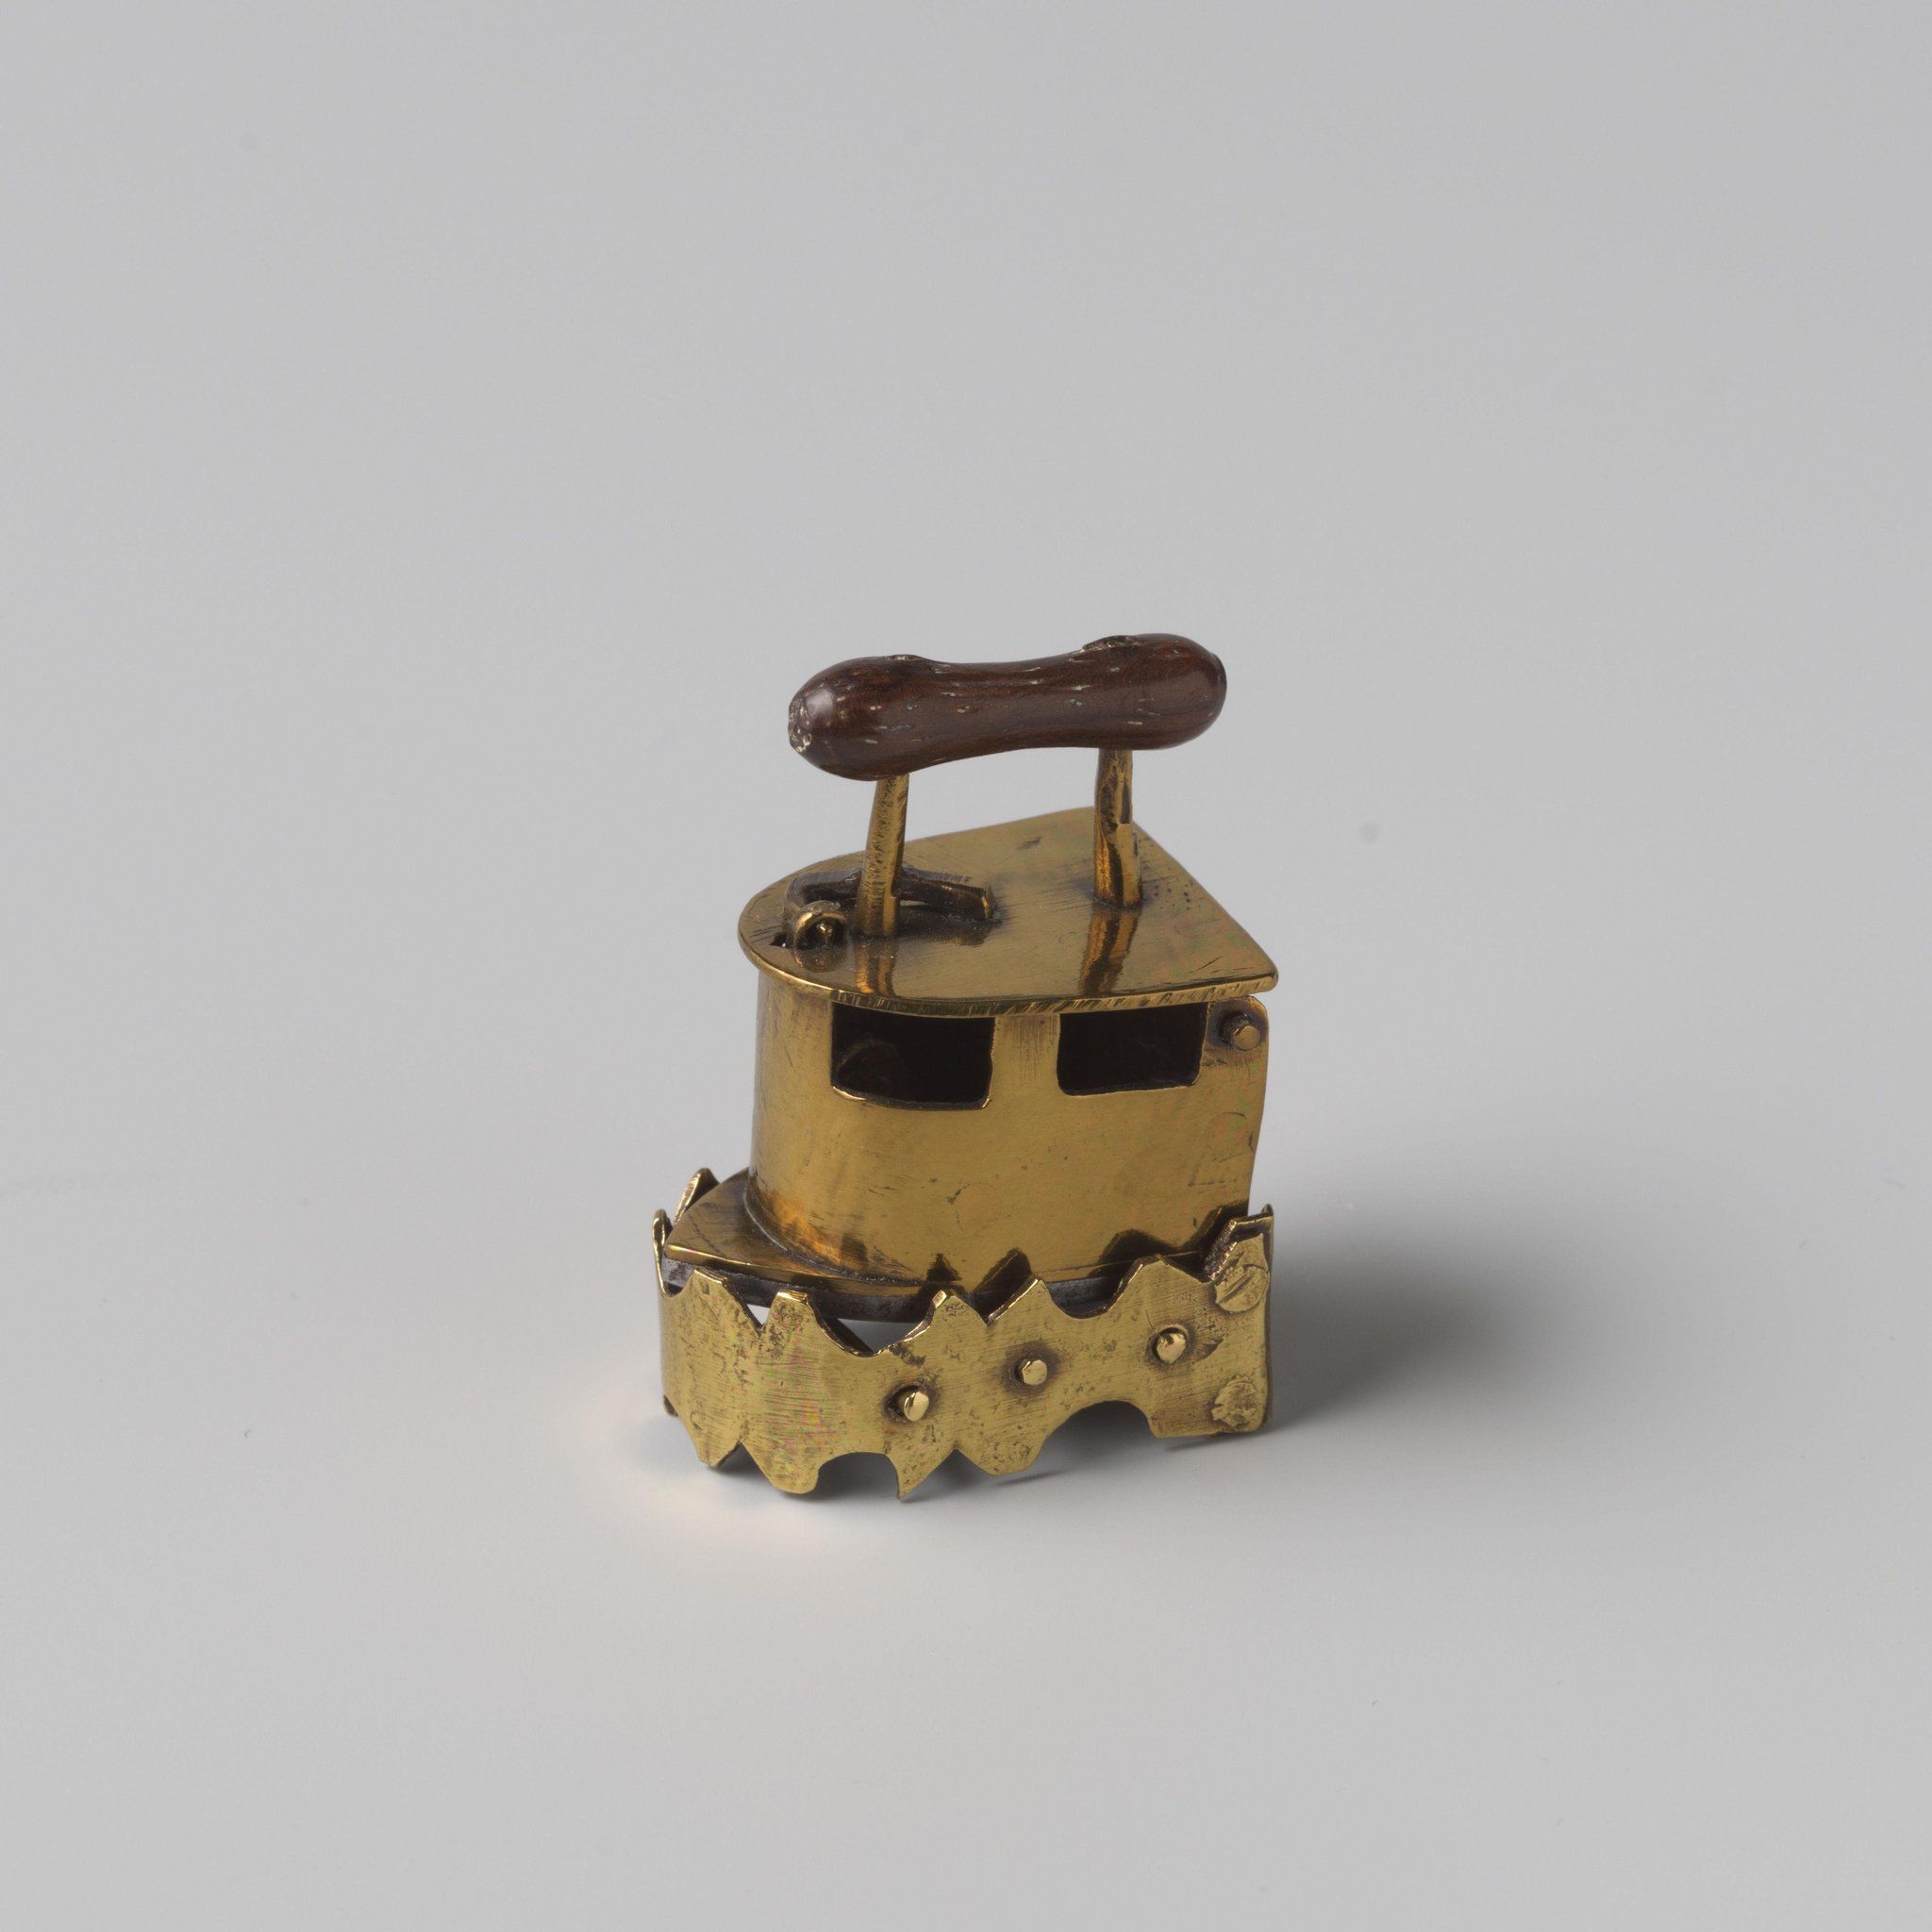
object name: miniature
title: Rooster voor een houtskoolstrijkijzer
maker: Anonymous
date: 1690-1710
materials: copper, wood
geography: amsterdam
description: Rooster voor een houtskoolstrijkijzer, bestaande uit drie spijlen in geschulpt gezaagde rand. Opmerking: Hoort bij strijkijzer (BK-NM-1010-260-A).